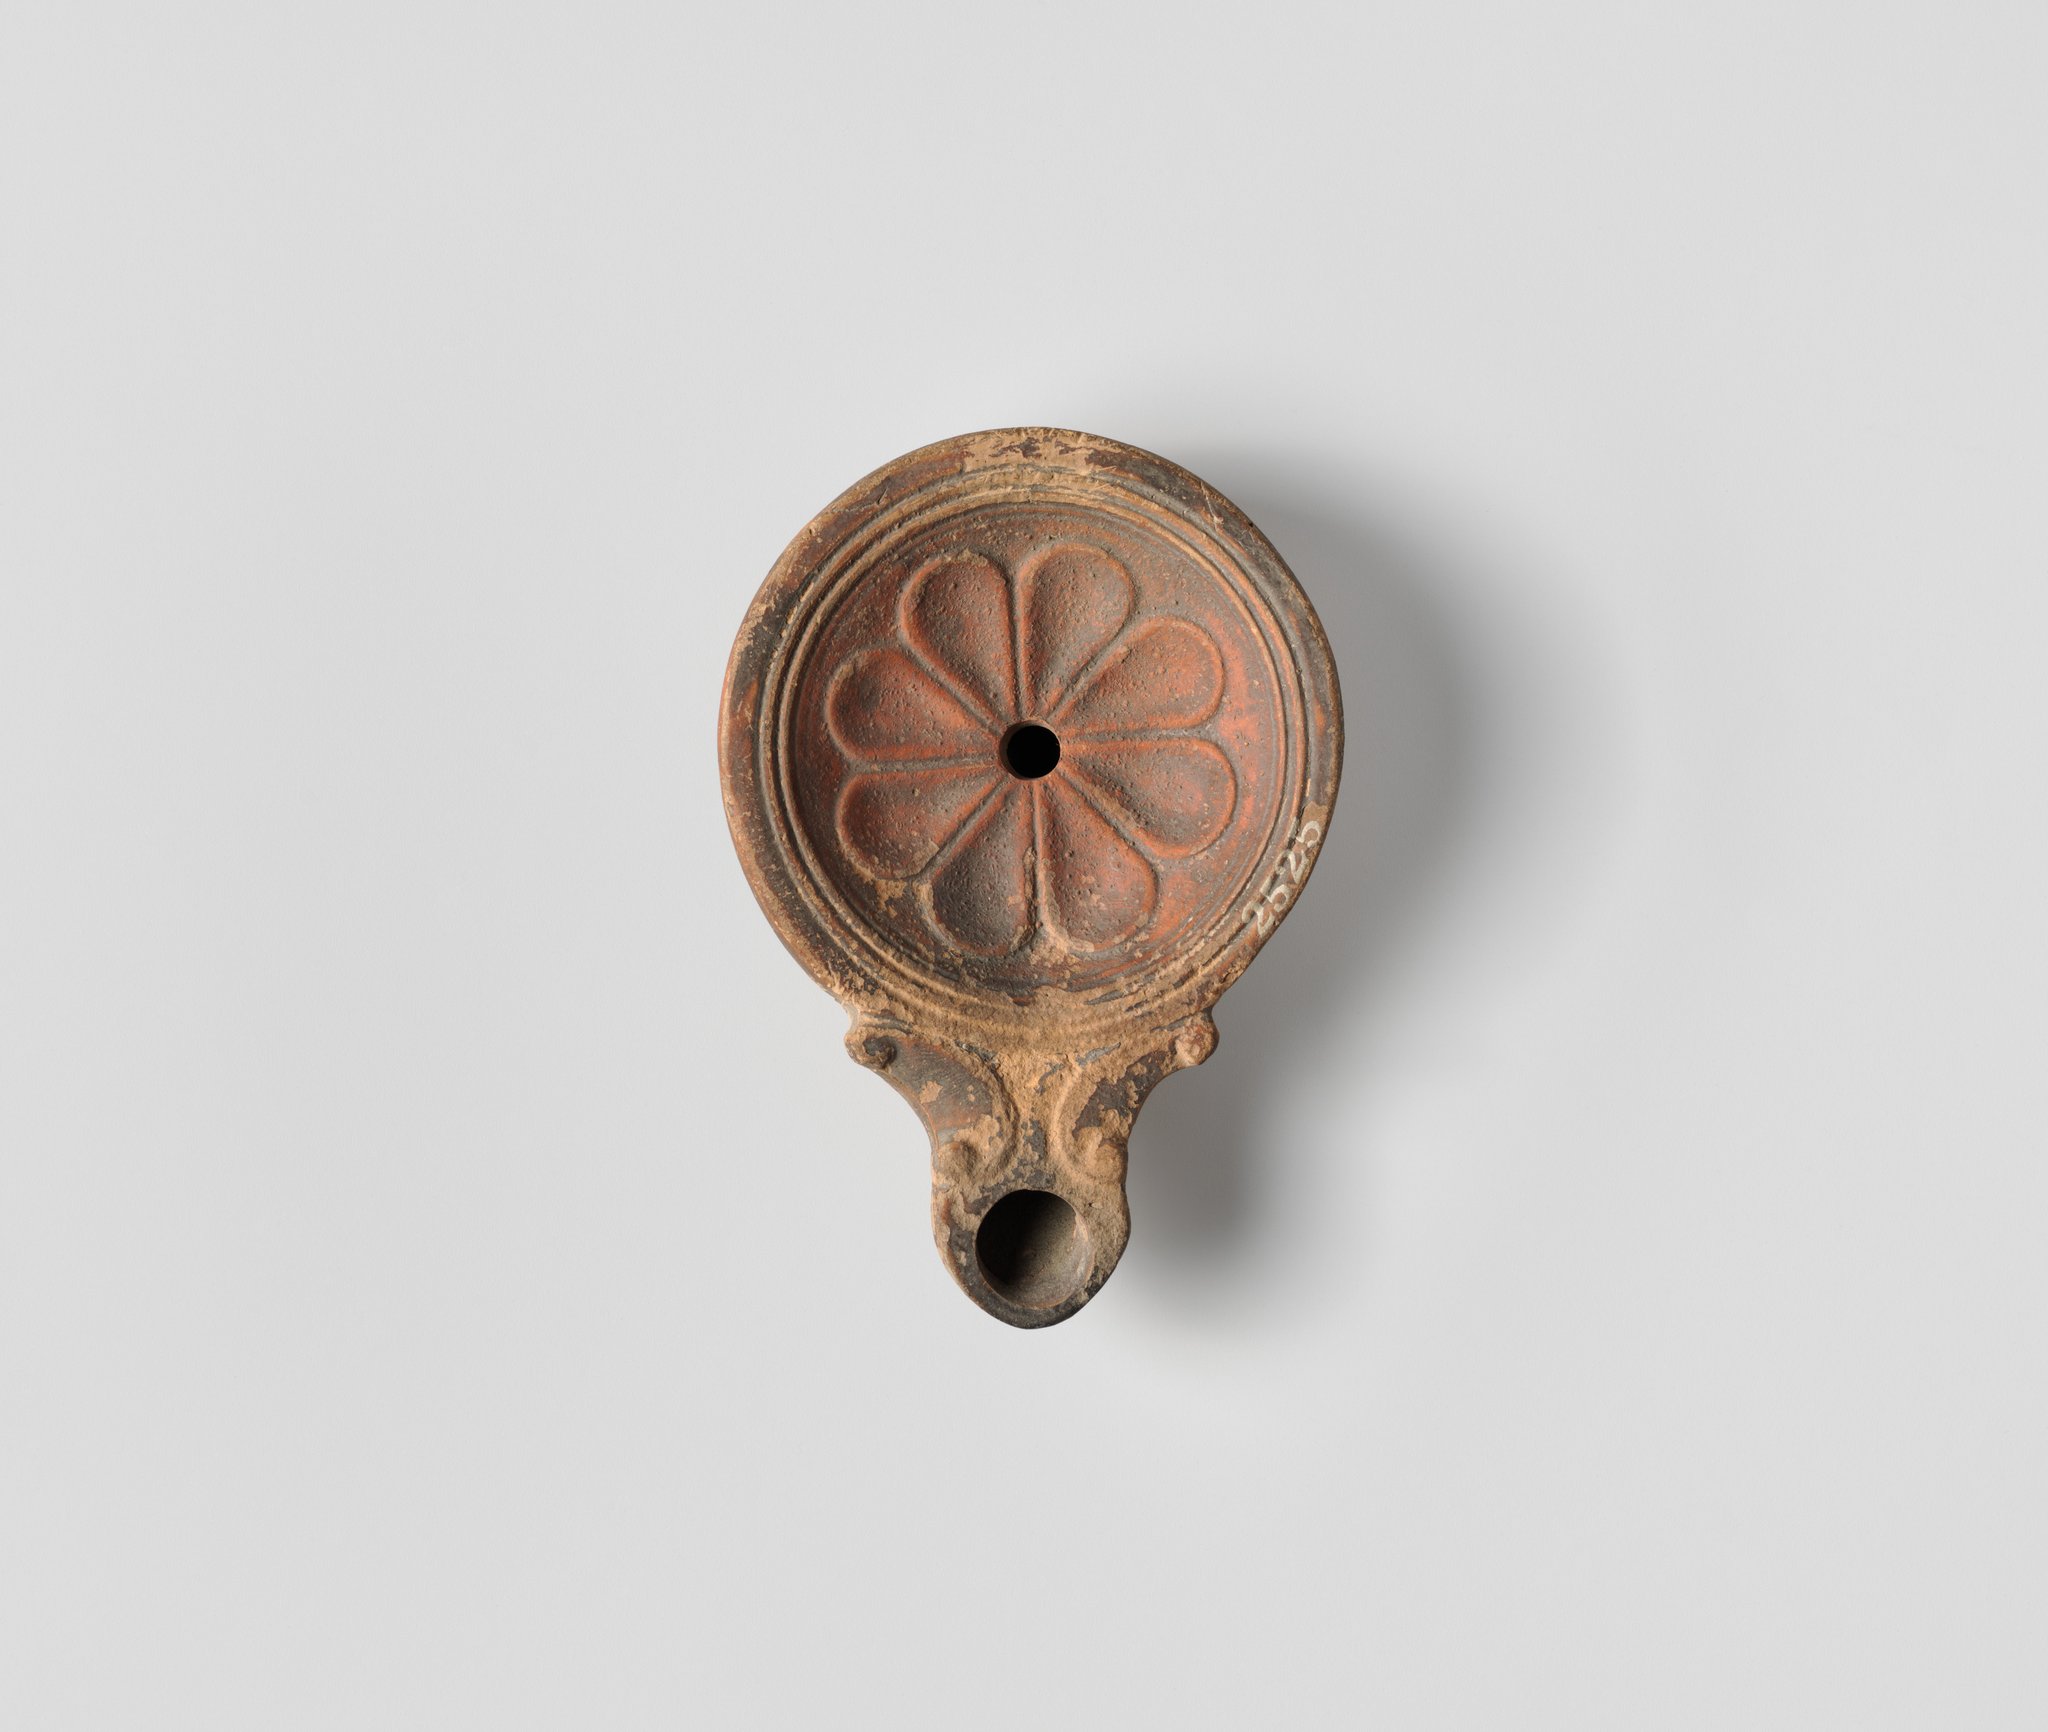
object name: lamp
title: Terracotta oil lamp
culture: roman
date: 100 BCE-100 CE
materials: terracotta